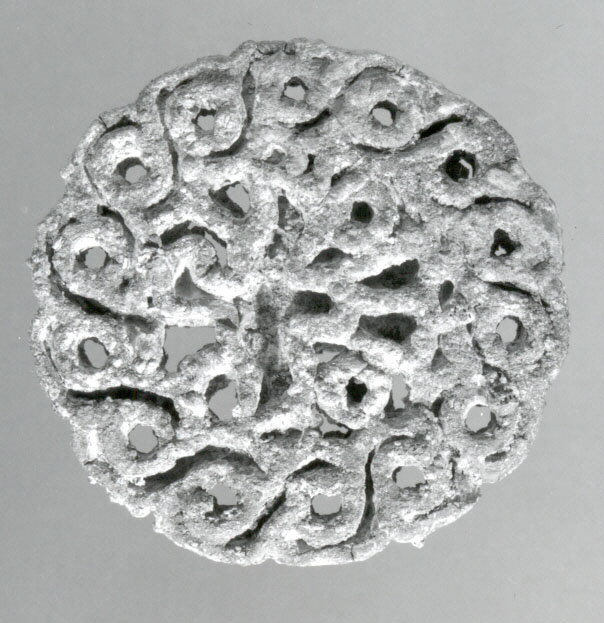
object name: stamp seal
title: Compartmented stamp seal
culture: bactria-margiana archaeological complex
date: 2333-1668 BCE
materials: copper alloy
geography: bactria-margiana